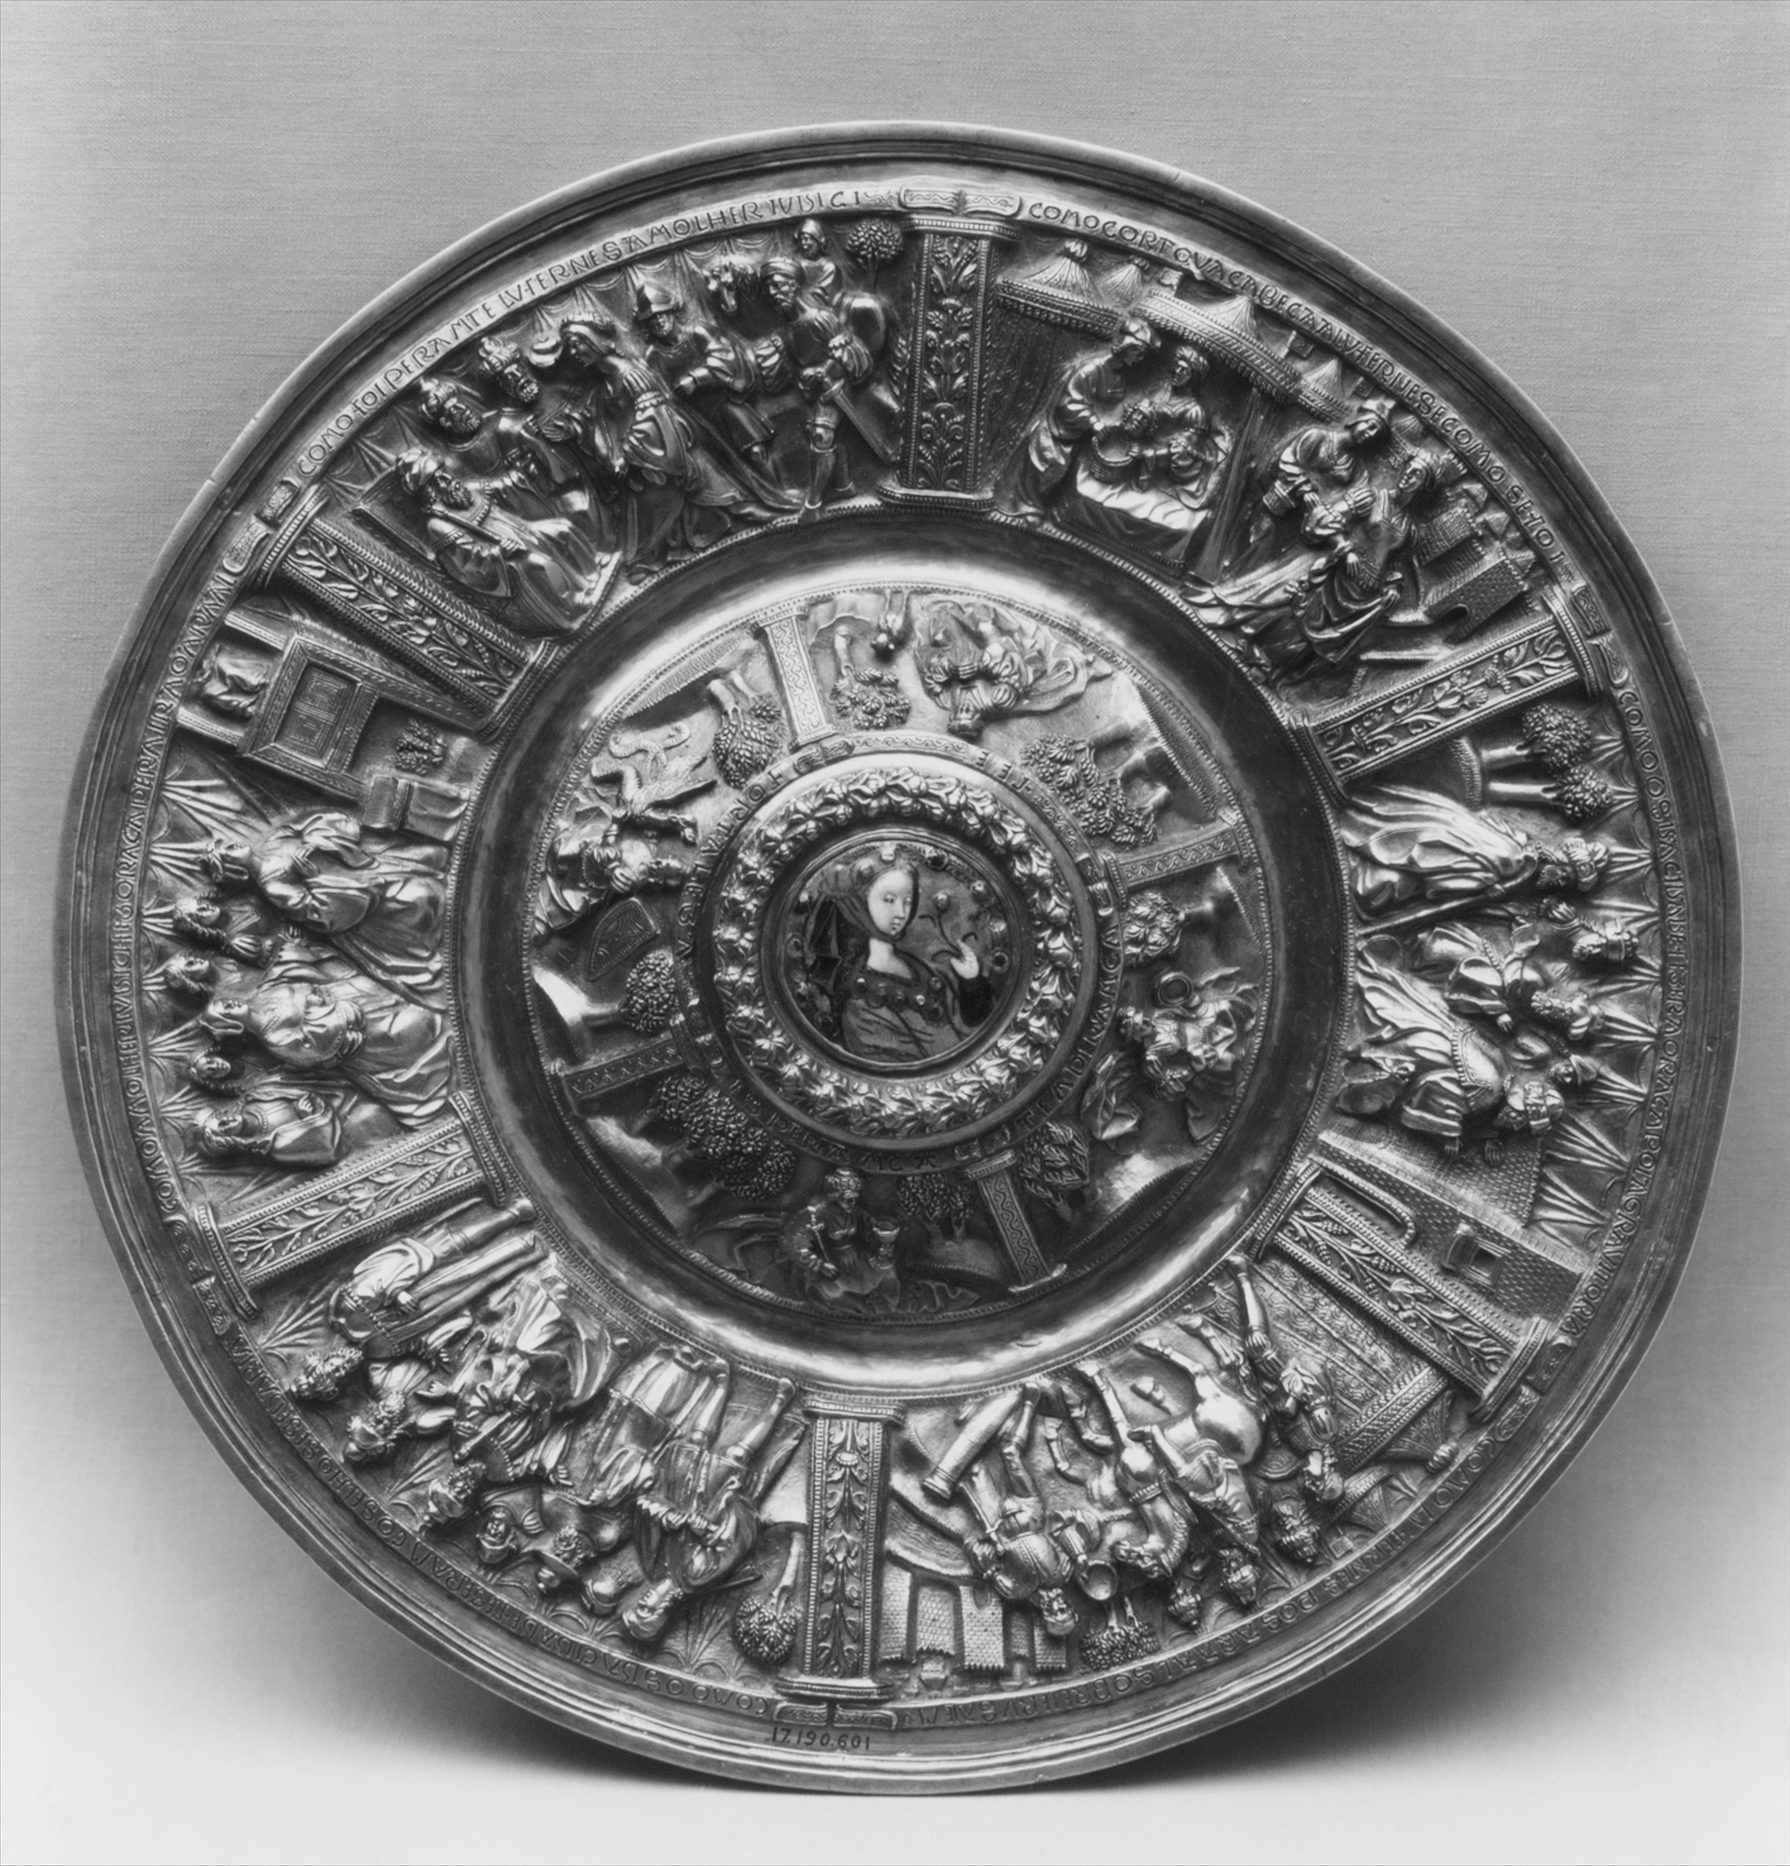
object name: plateau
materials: copper, enamel, silver gilt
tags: men,portraits,women